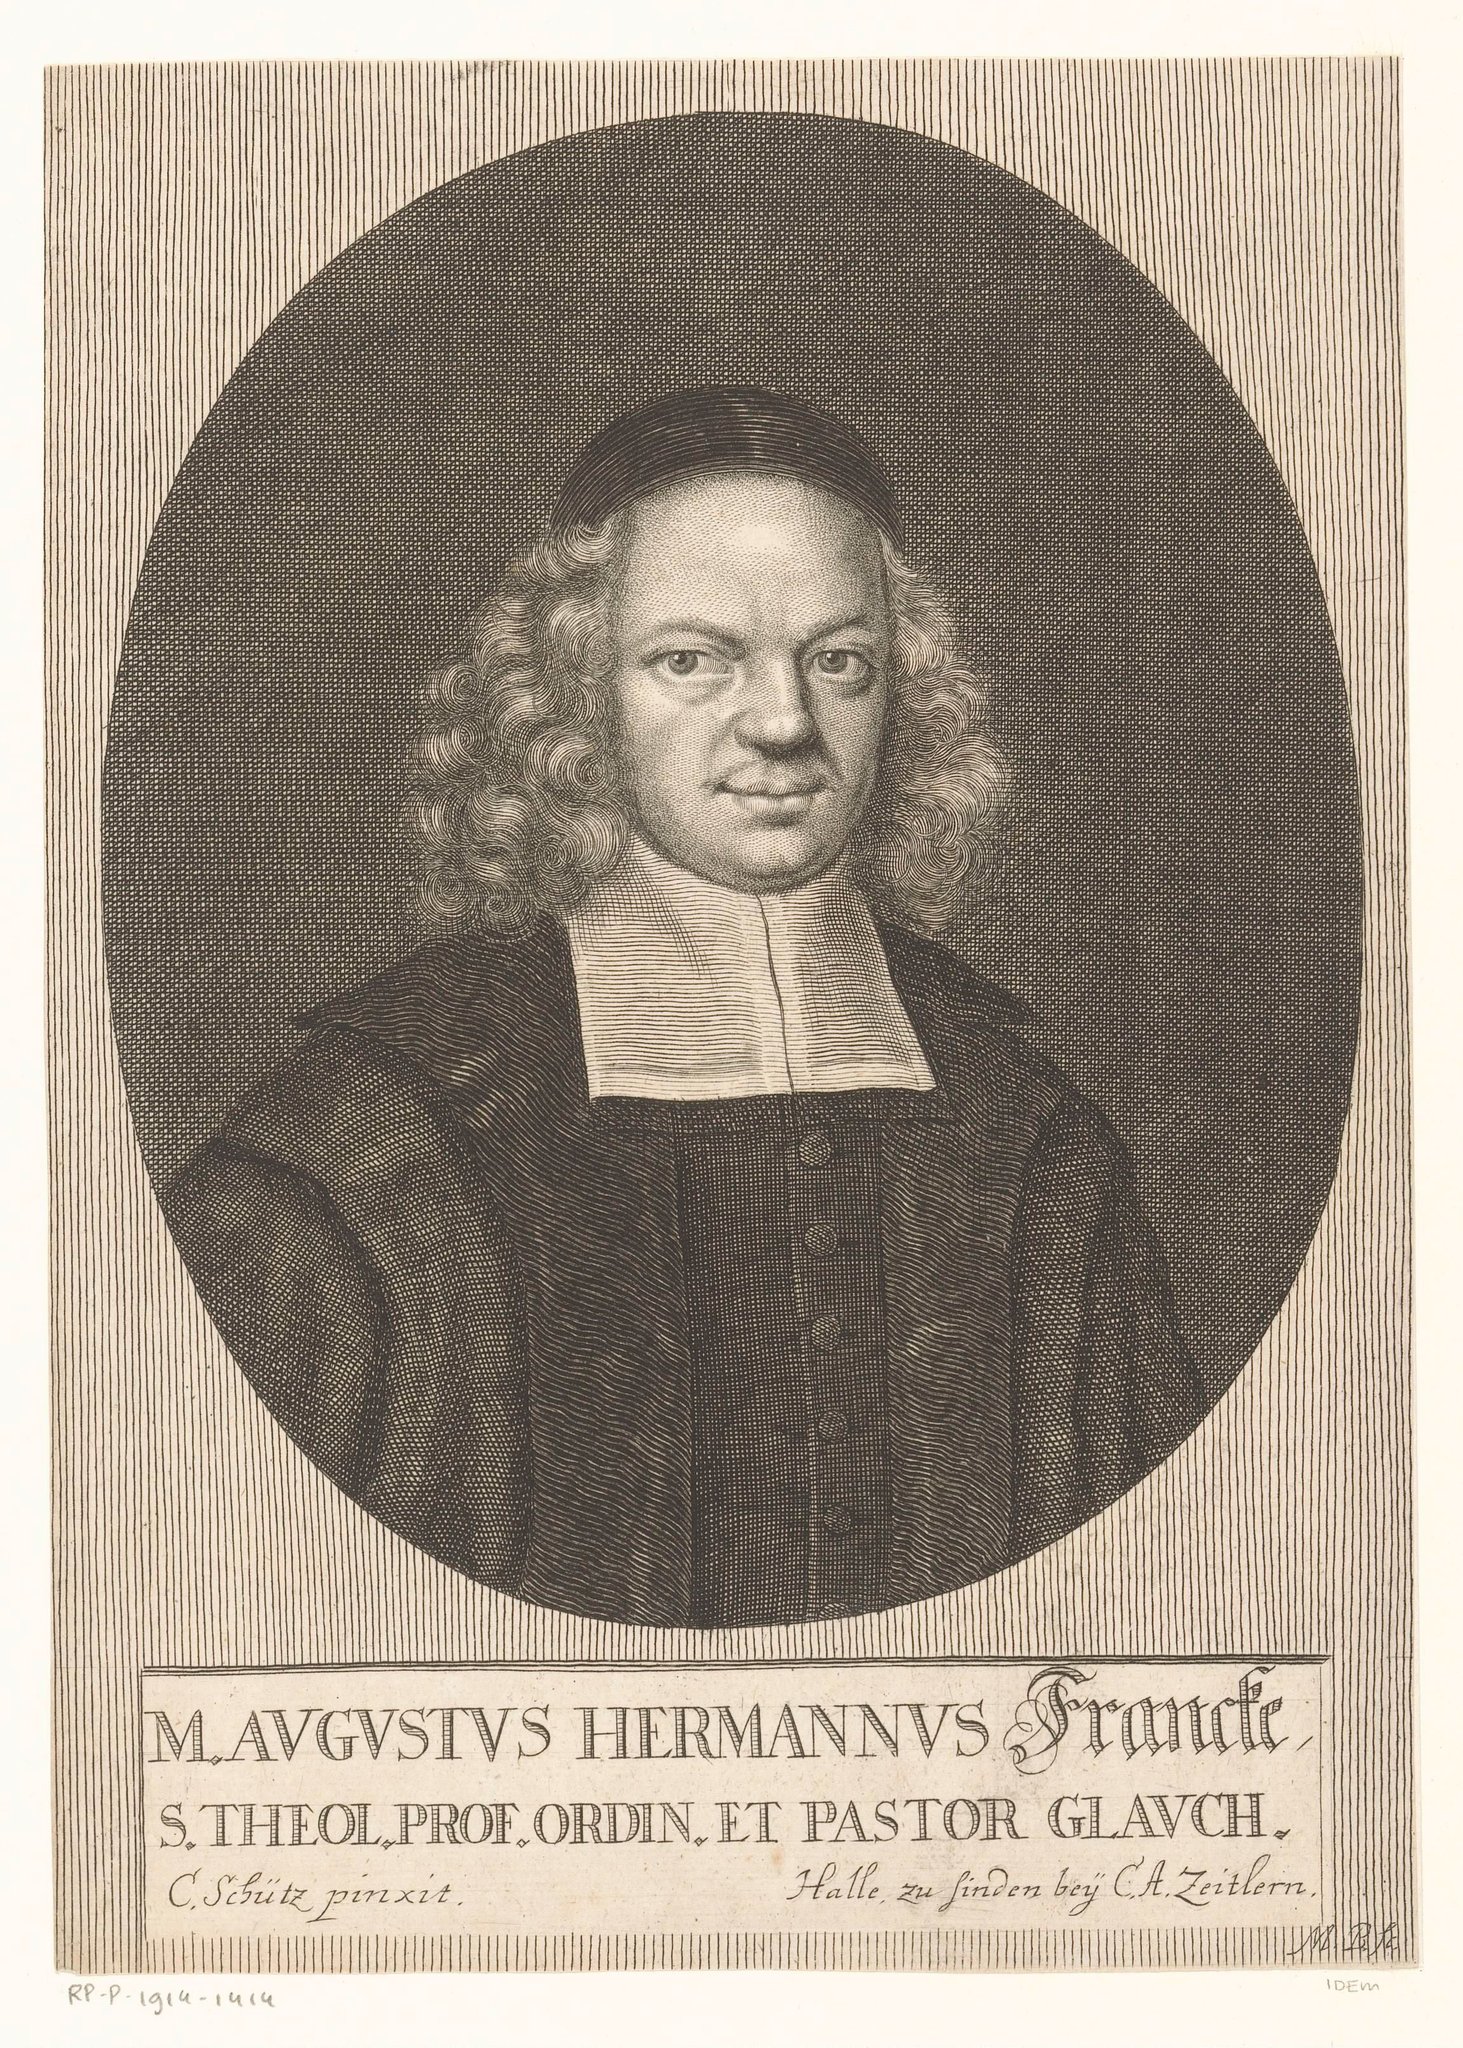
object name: print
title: Portret van August Hermann Francke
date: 1694-1715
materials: paper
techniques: engraving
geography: leipzig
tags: historical persons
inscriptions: collector's mark: Lugt 2228